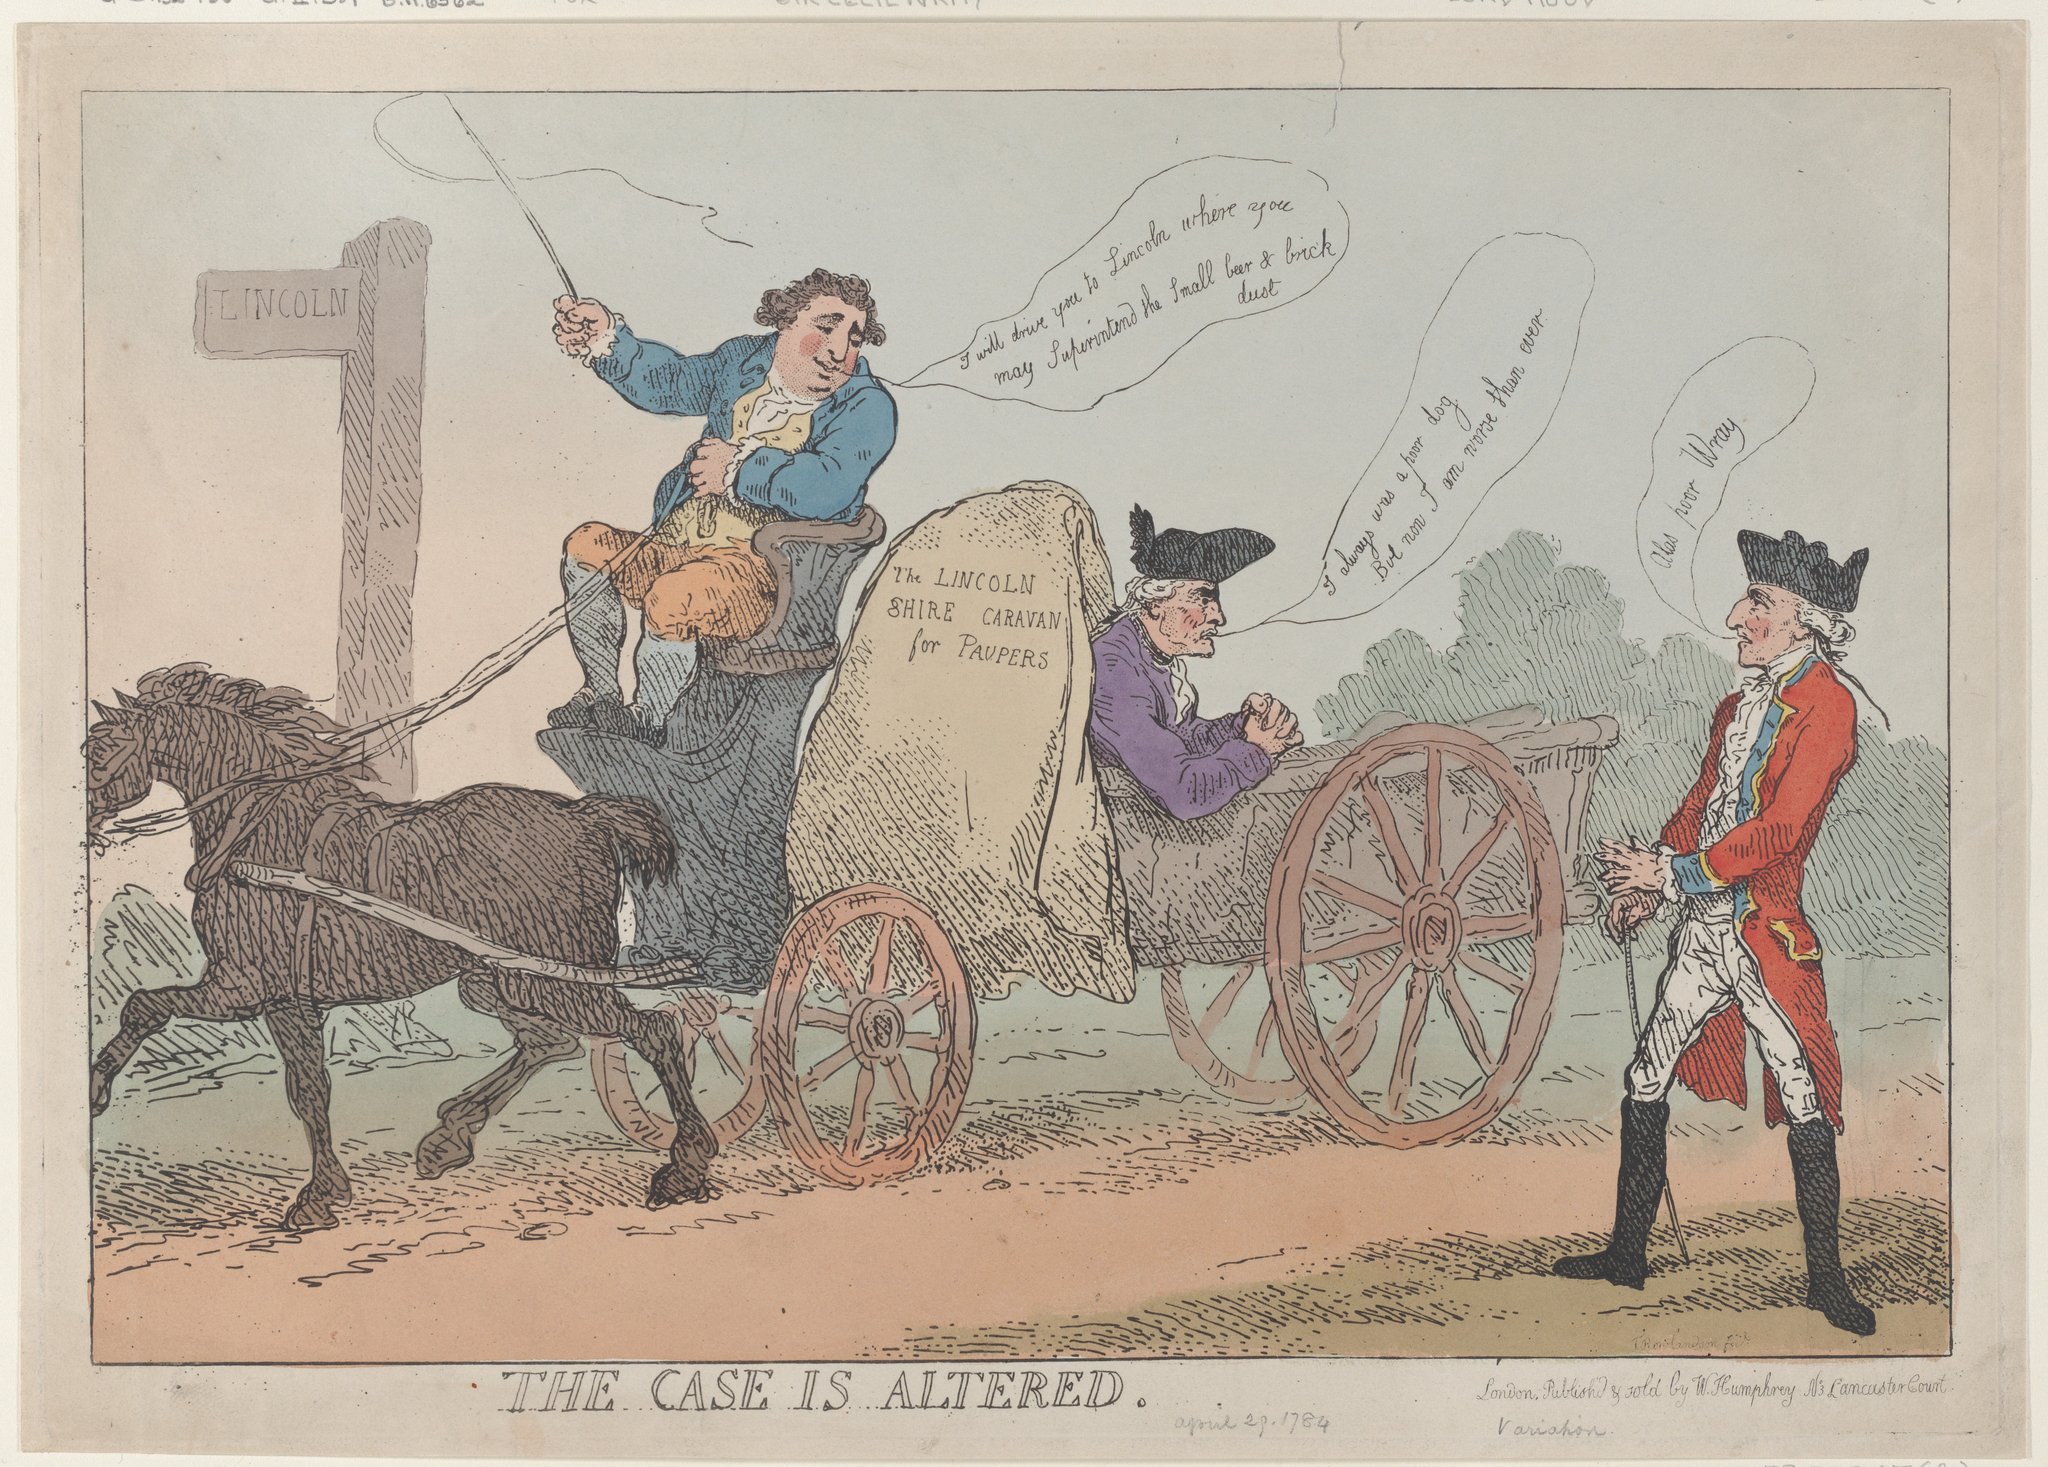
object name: print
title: The Case Is Altered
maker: thomas rowlandson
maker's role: artist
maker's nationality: british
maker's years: 1757-1827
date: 1784-1786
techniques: etching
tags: satire,men,horses,carts